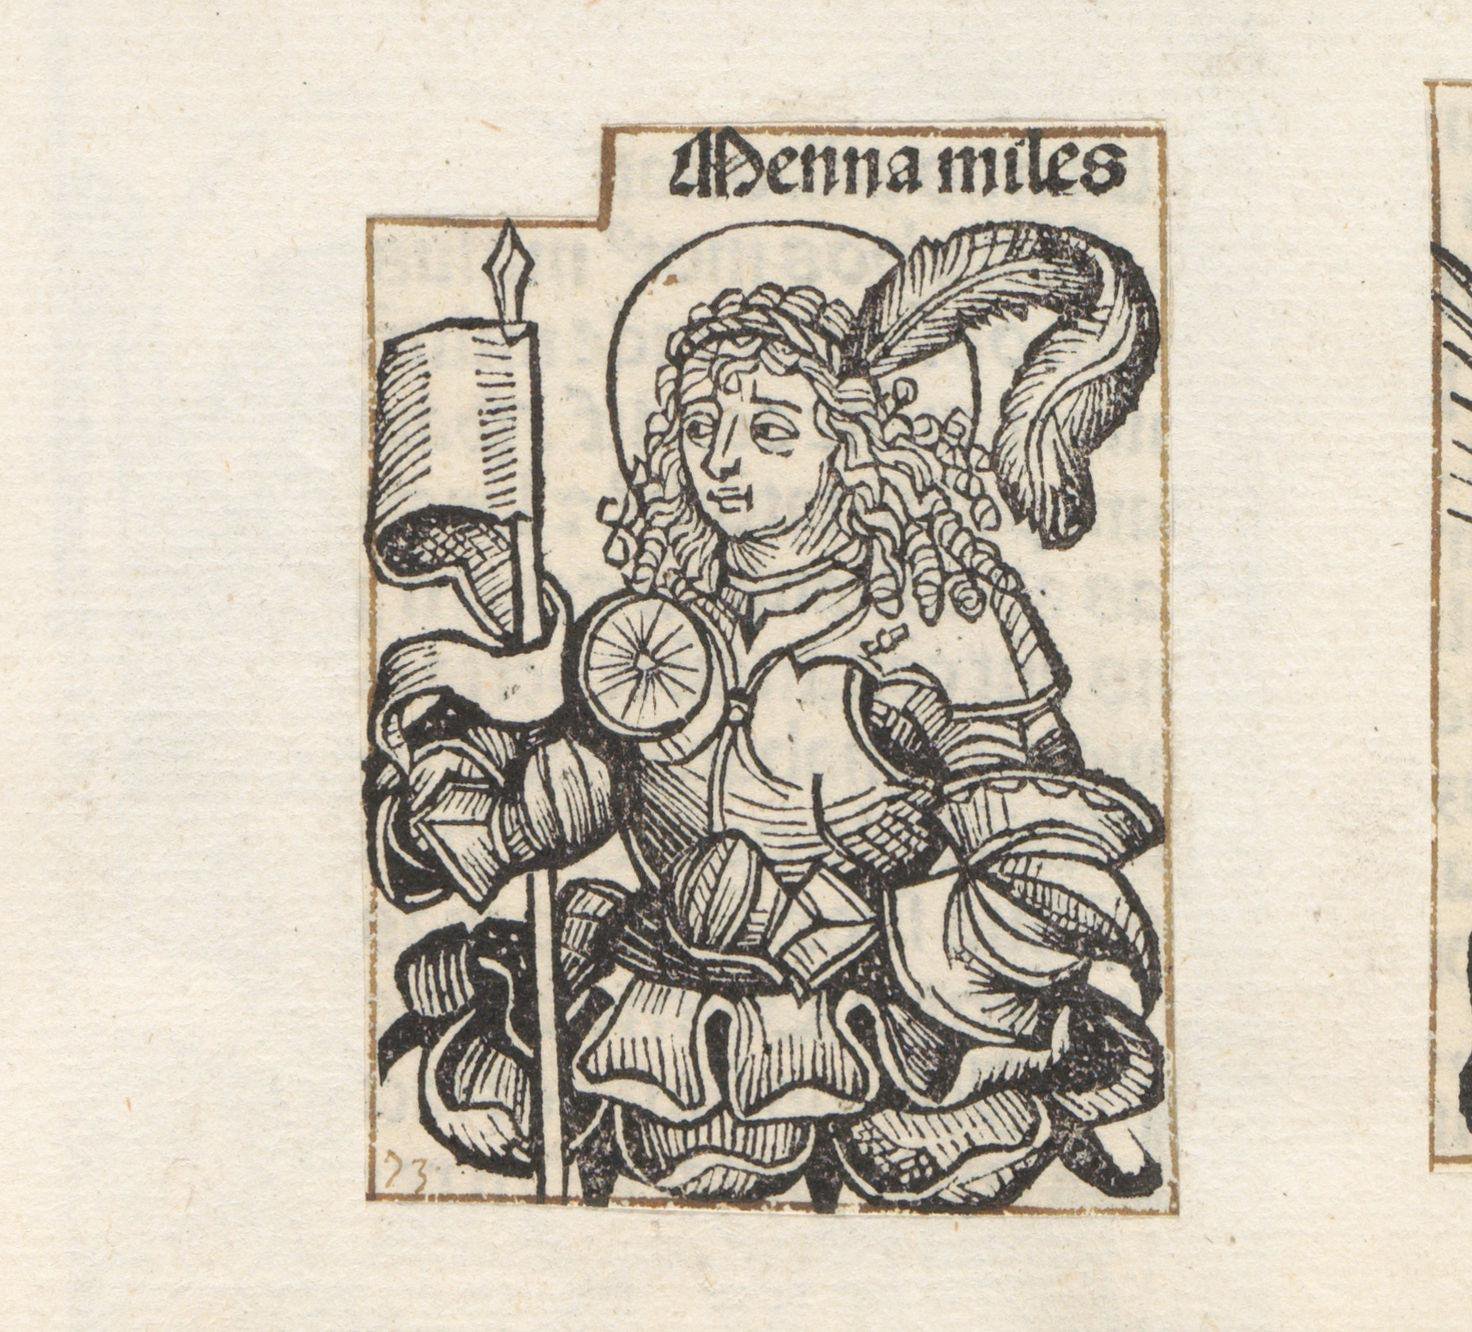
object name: book illustration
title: Menas van Alexandrië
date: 1493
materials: paper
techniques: letterpress printing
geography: nuremberg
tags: saints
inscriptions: inscription: ‘73’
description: De houtsnede wordt herhaaldelijk gebruikt als boekillustratie in de Liber Chronicarum (of Neurenbergkroniek) van Hartmann Schedel, verschenen in het Latijn en Duits in 1493. Zie de Latijnse uitgave, folio 127v.